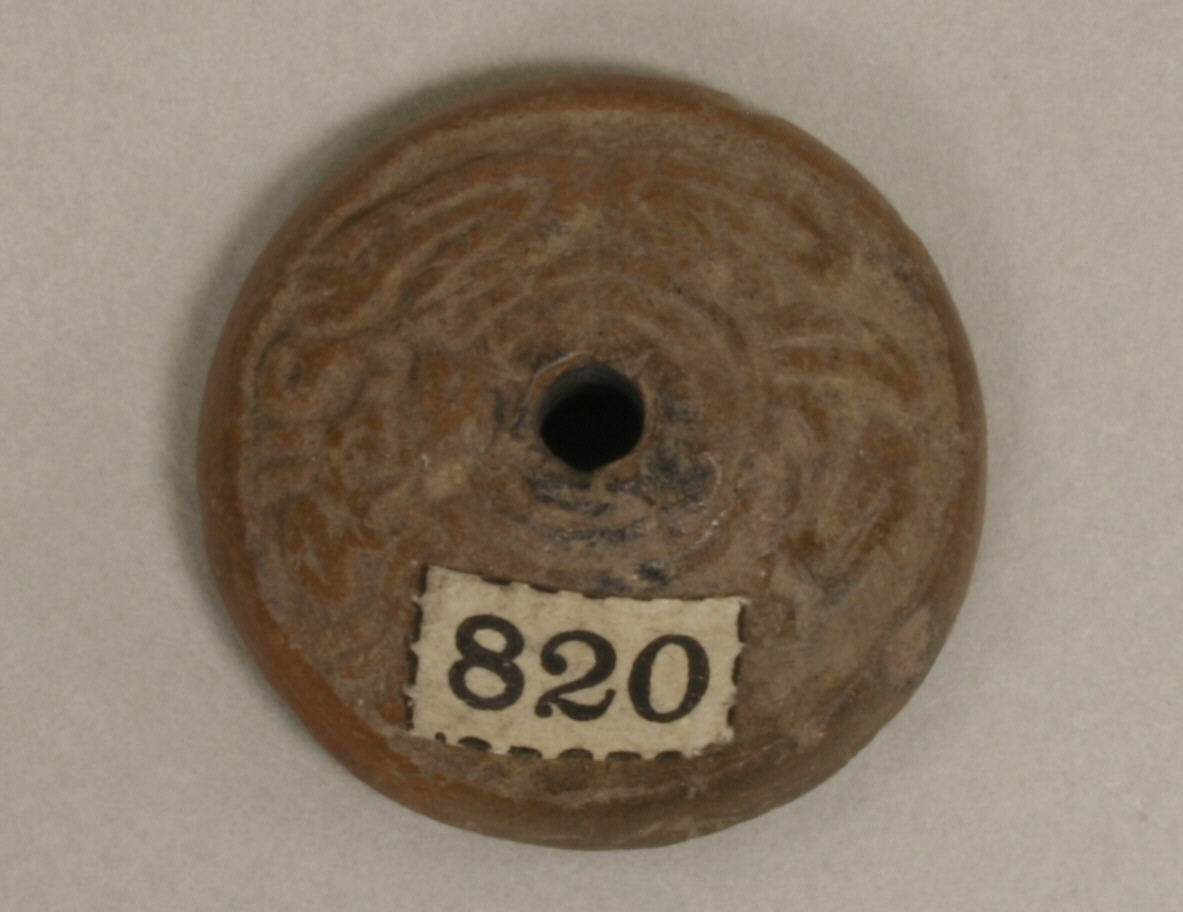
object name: spindle whorl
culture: mexican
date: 901-1533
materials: ceramic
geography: mexico